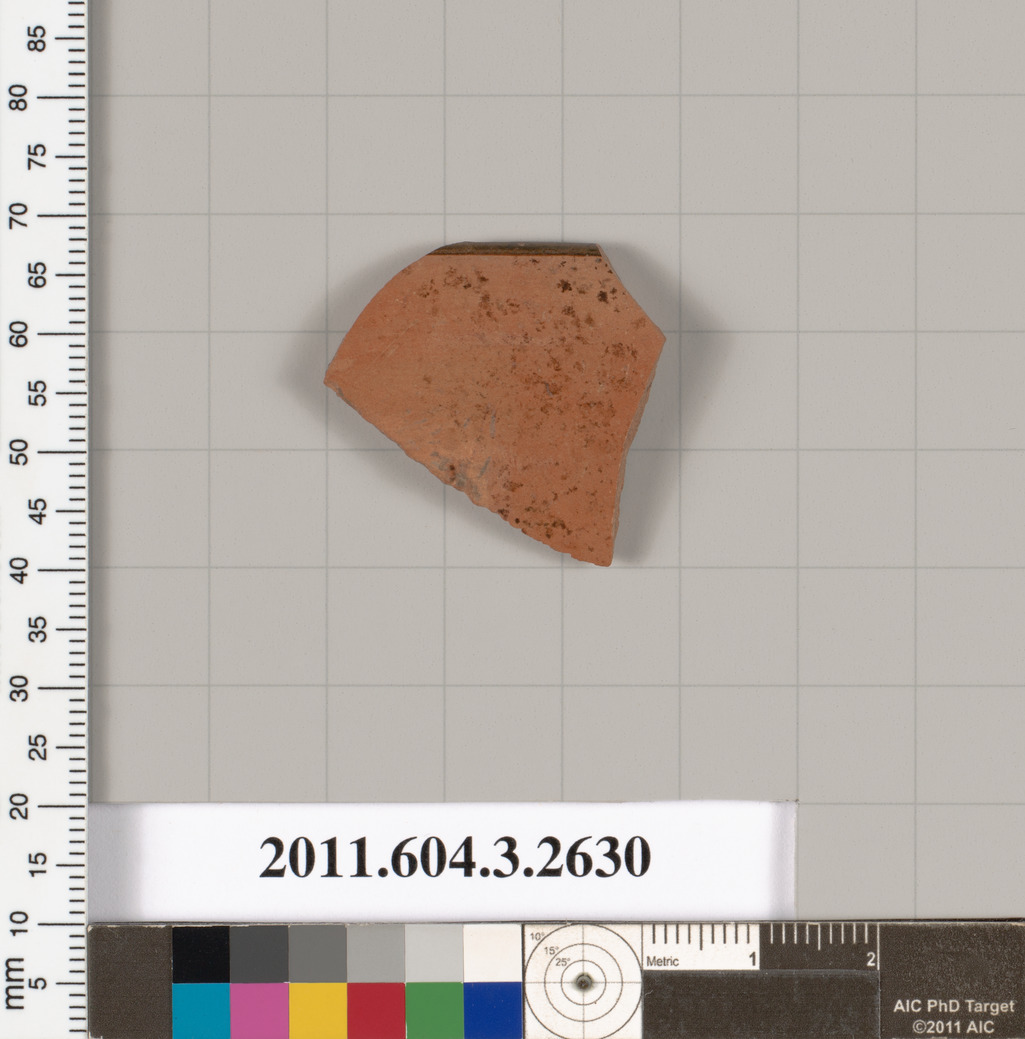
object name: kylix fragment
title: Terracotta rim fragment of a kylix (drinking cup)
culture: greek, attic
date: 600-401 BCE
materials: terracotta